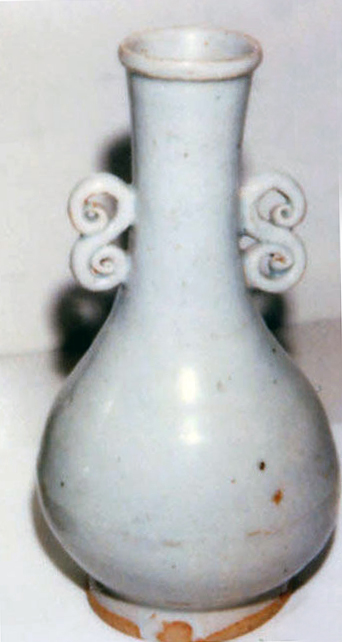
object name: vase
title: Vase (one of a pair)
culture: chinese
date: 1301-1400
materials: glaze, porcelain